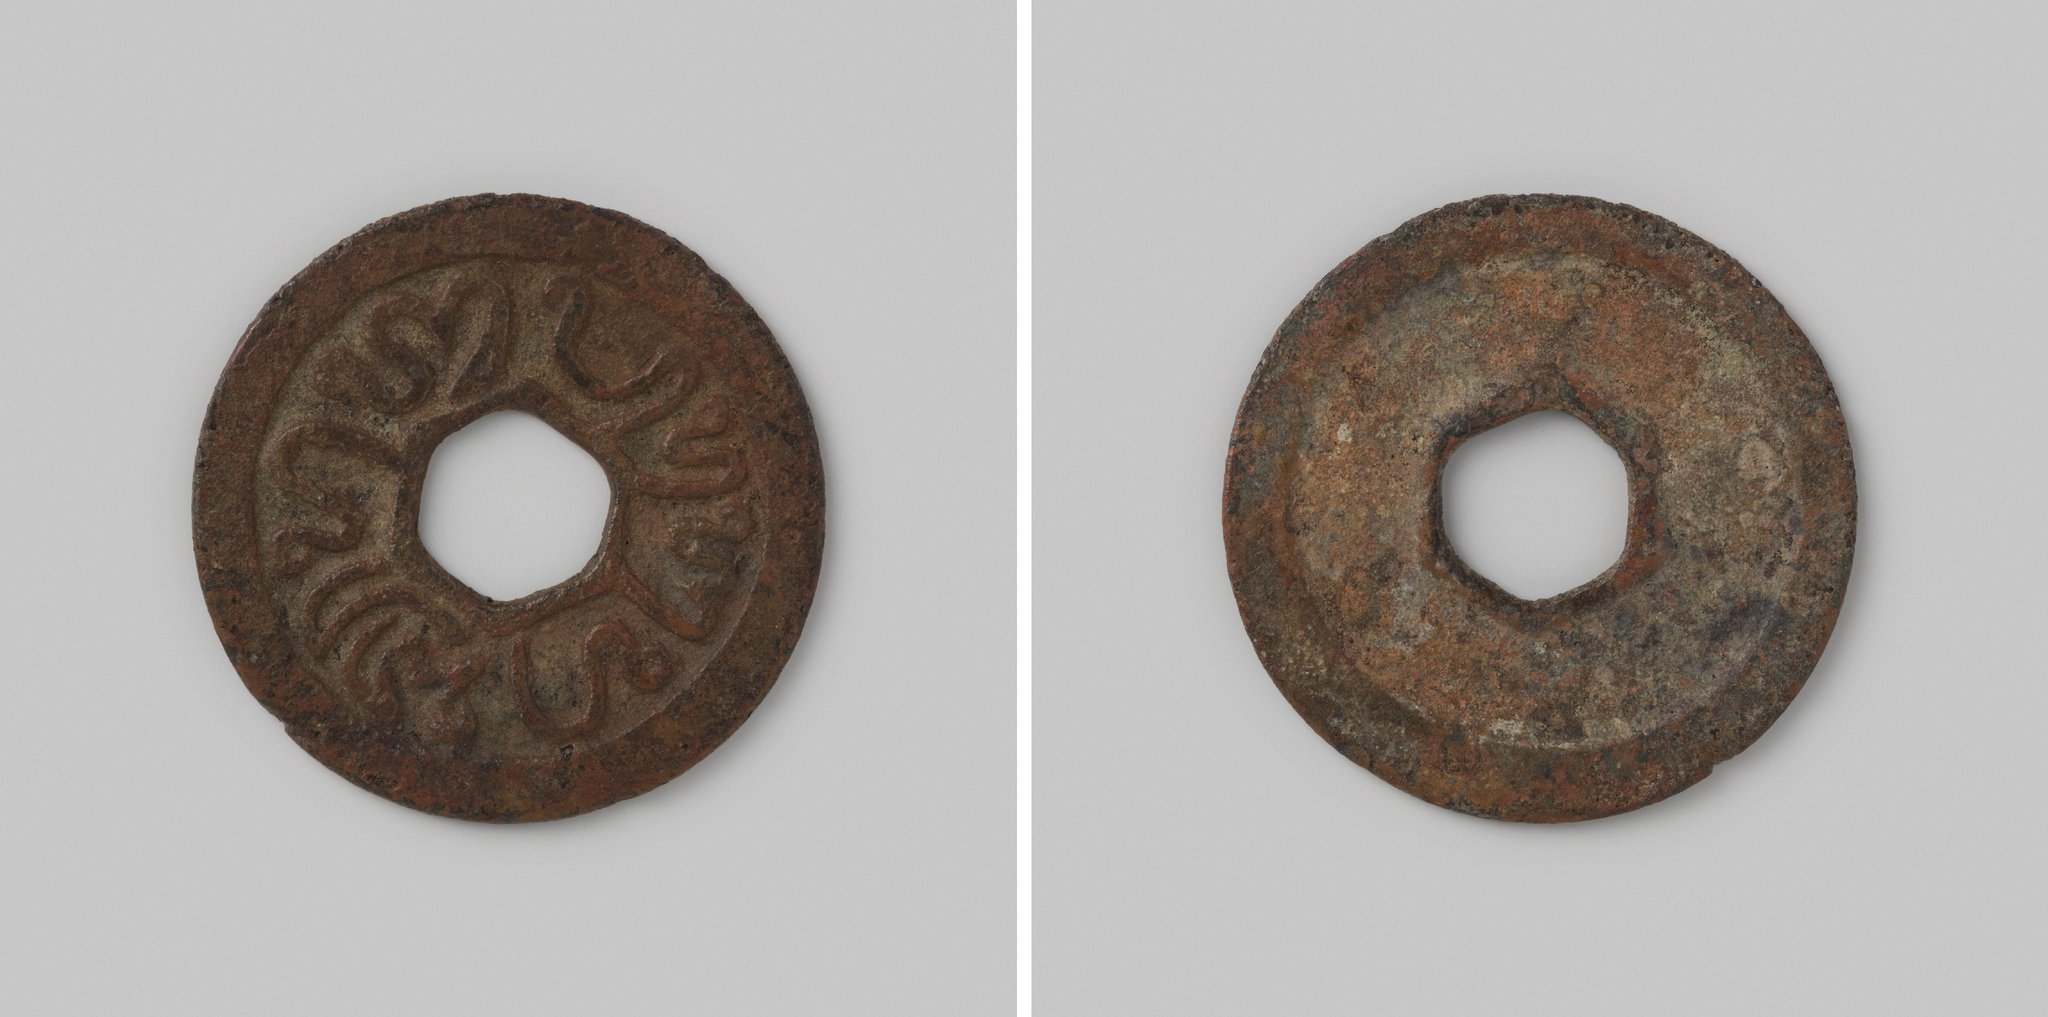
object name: coin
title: Bantam, Java, pitji of keteng Moelana Mohammed Sedo-ning Rana, 988-1005 [= 1580-1596] of van regent Pangeran aria Rana di Manggala, 1005-1016 [= 1596-1608],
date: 1580-1608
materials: copper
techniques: casting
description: Koperen munt. Voorzijde: binnen brede rand in Javaane lettertekens omschrift in het Javaans: pangeran ratu: heer vorst. Keerzijde: binnen brede rand glad oppervlak. In het midden zeshoekig gat.